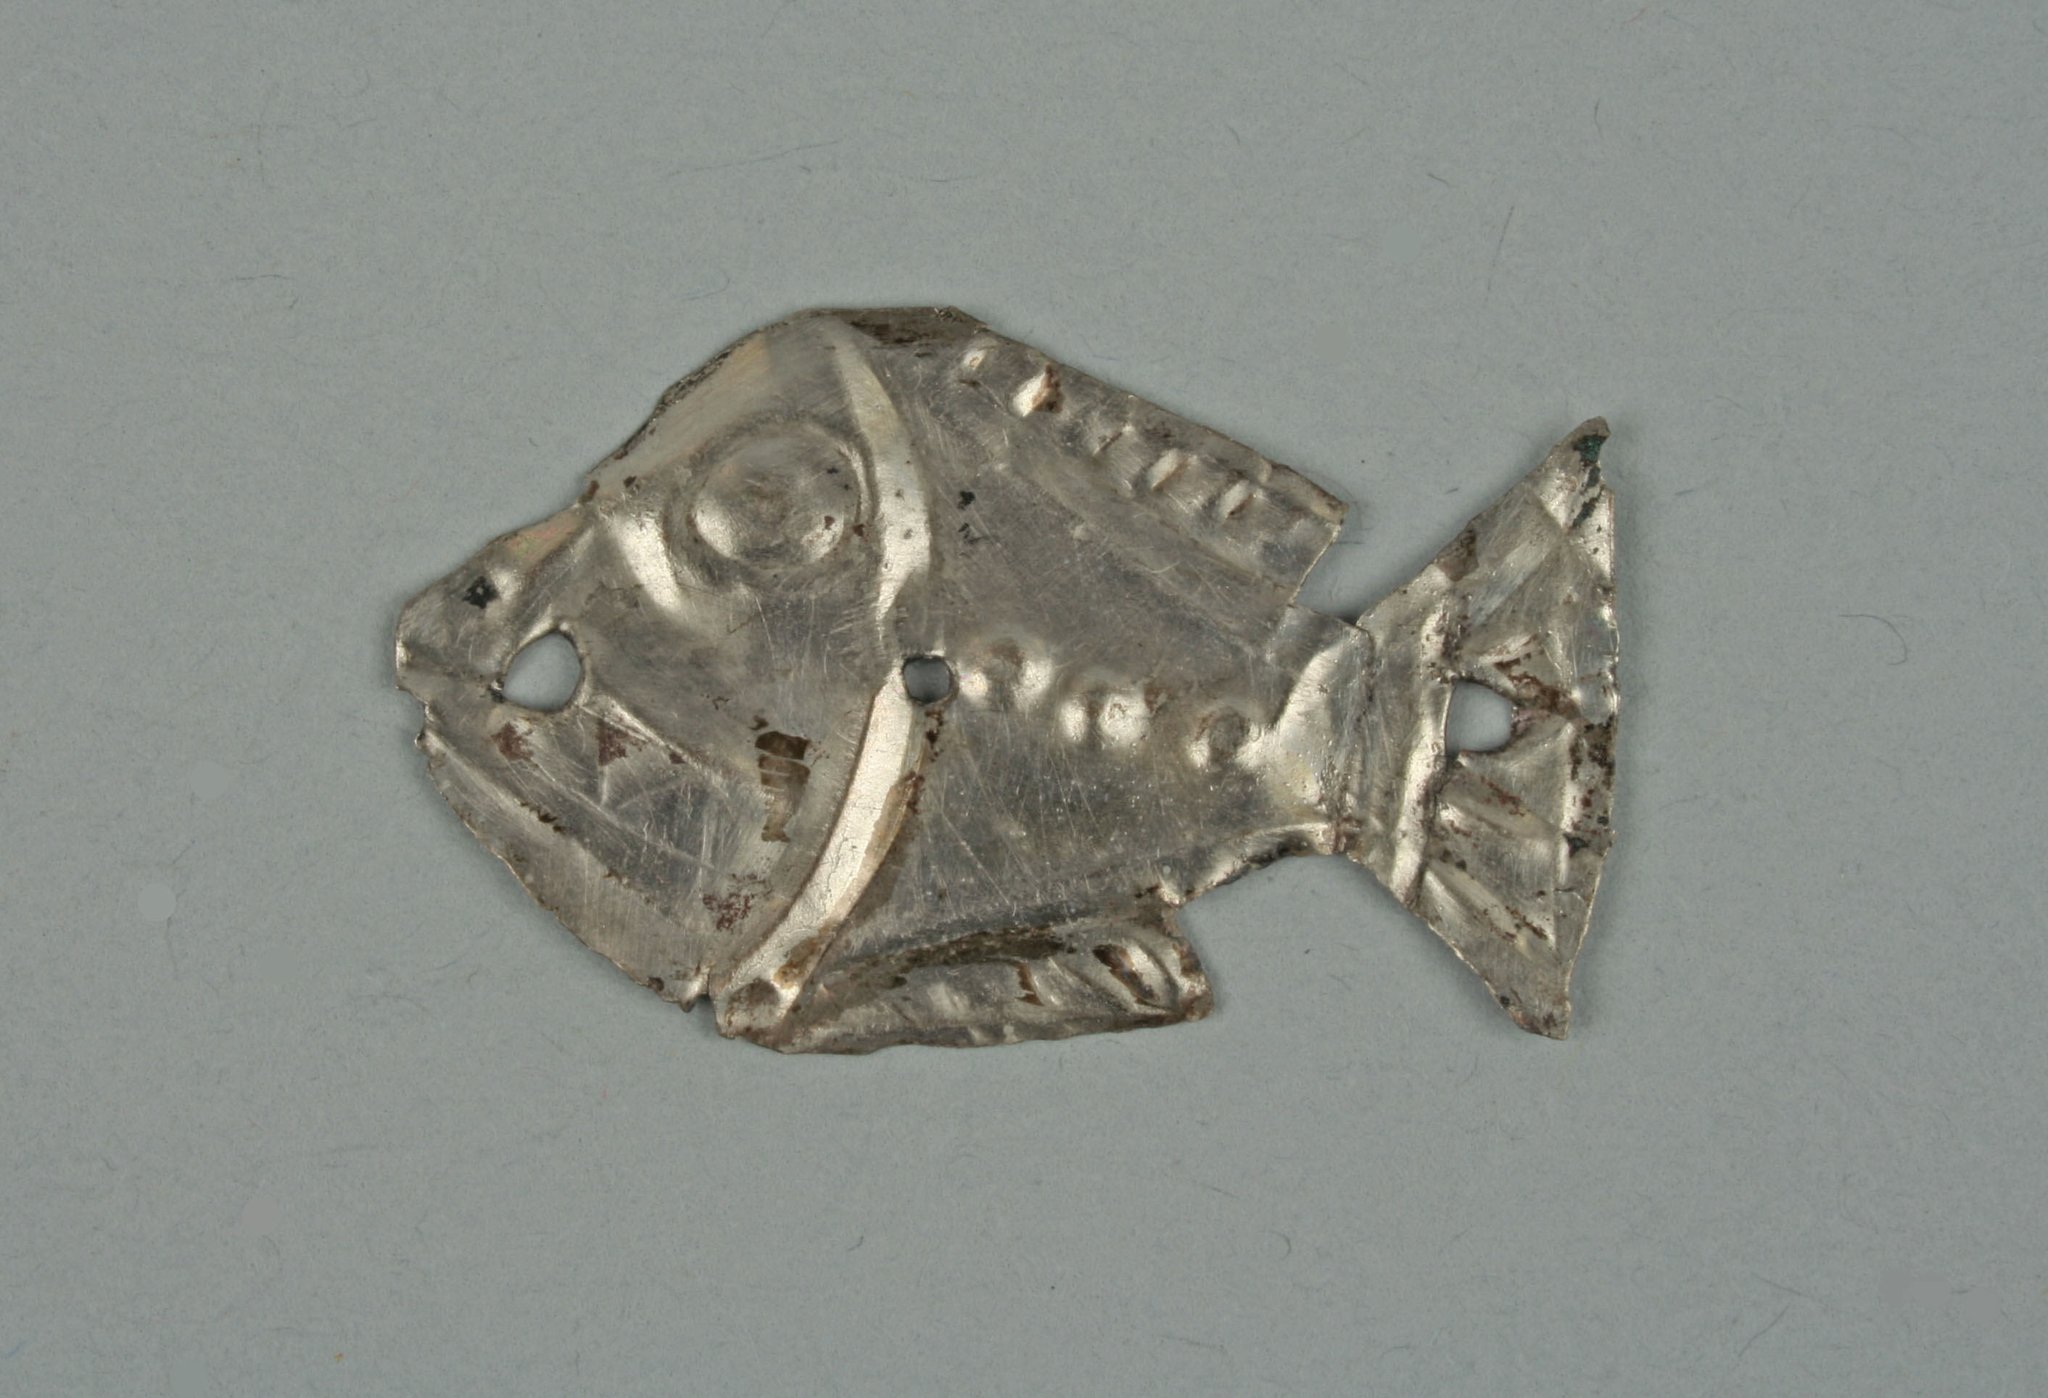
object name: ornament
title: Textile Ornament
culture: chimú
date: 1301-1500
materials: silver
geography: peru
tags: fish